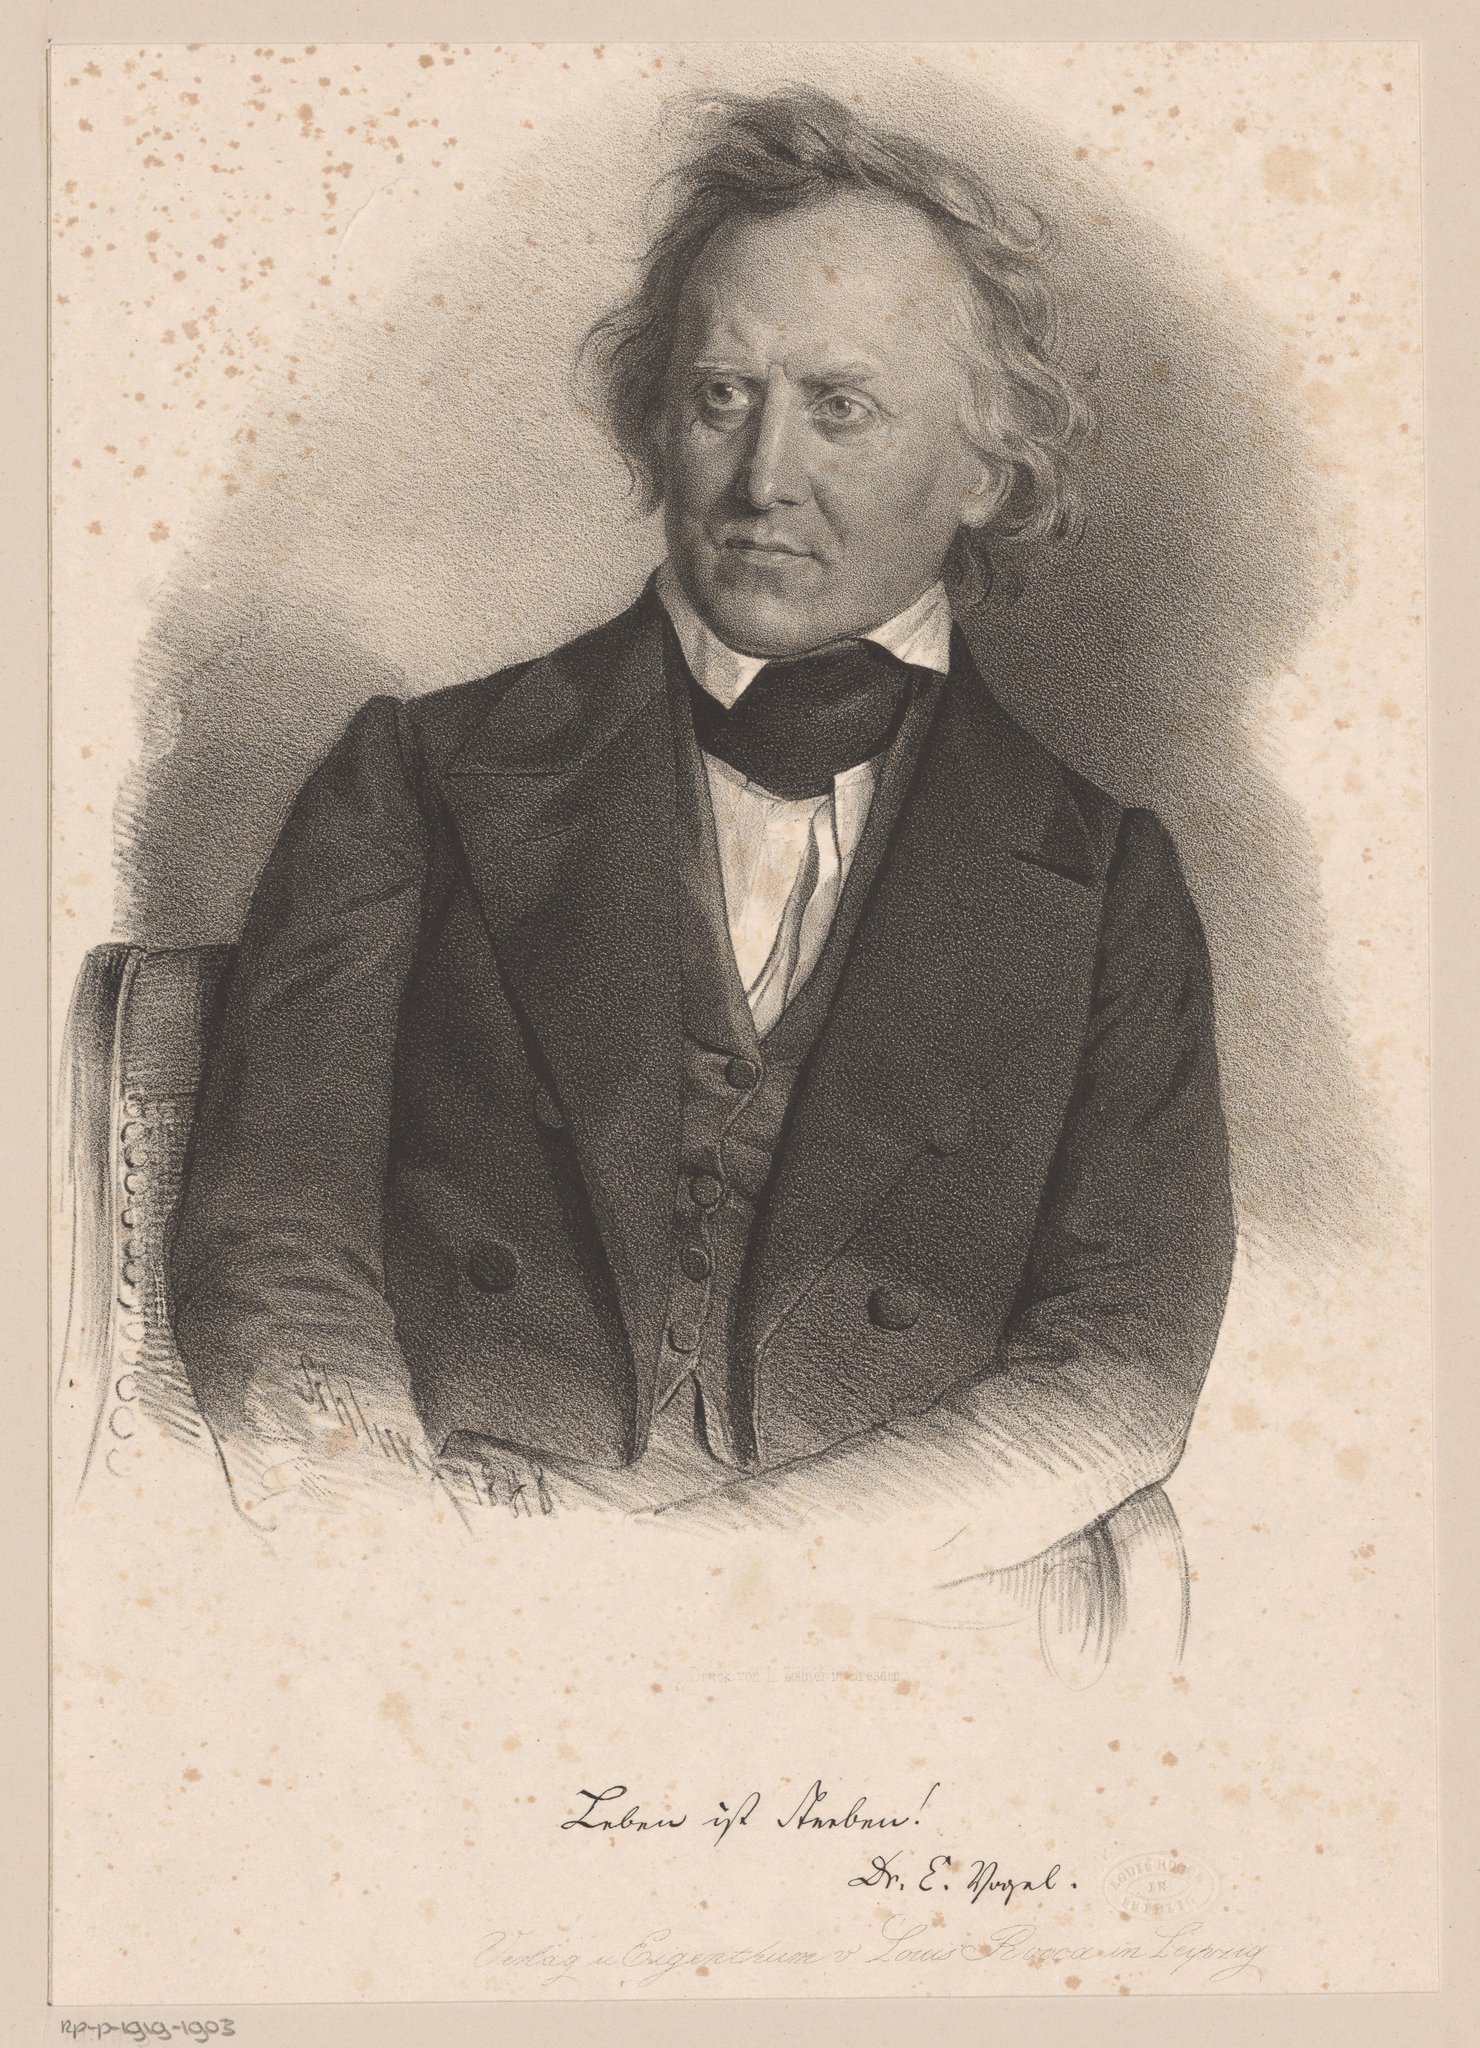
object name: print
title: Portret van een man, waarschijnlijk Ernst Gustav Vogel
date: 1848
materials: paper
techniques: lithograph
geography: leipzig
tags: historical persons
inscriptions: check stamp: ‘Louis Rocca in Leipzig’, collector's mark: Lugt 2228